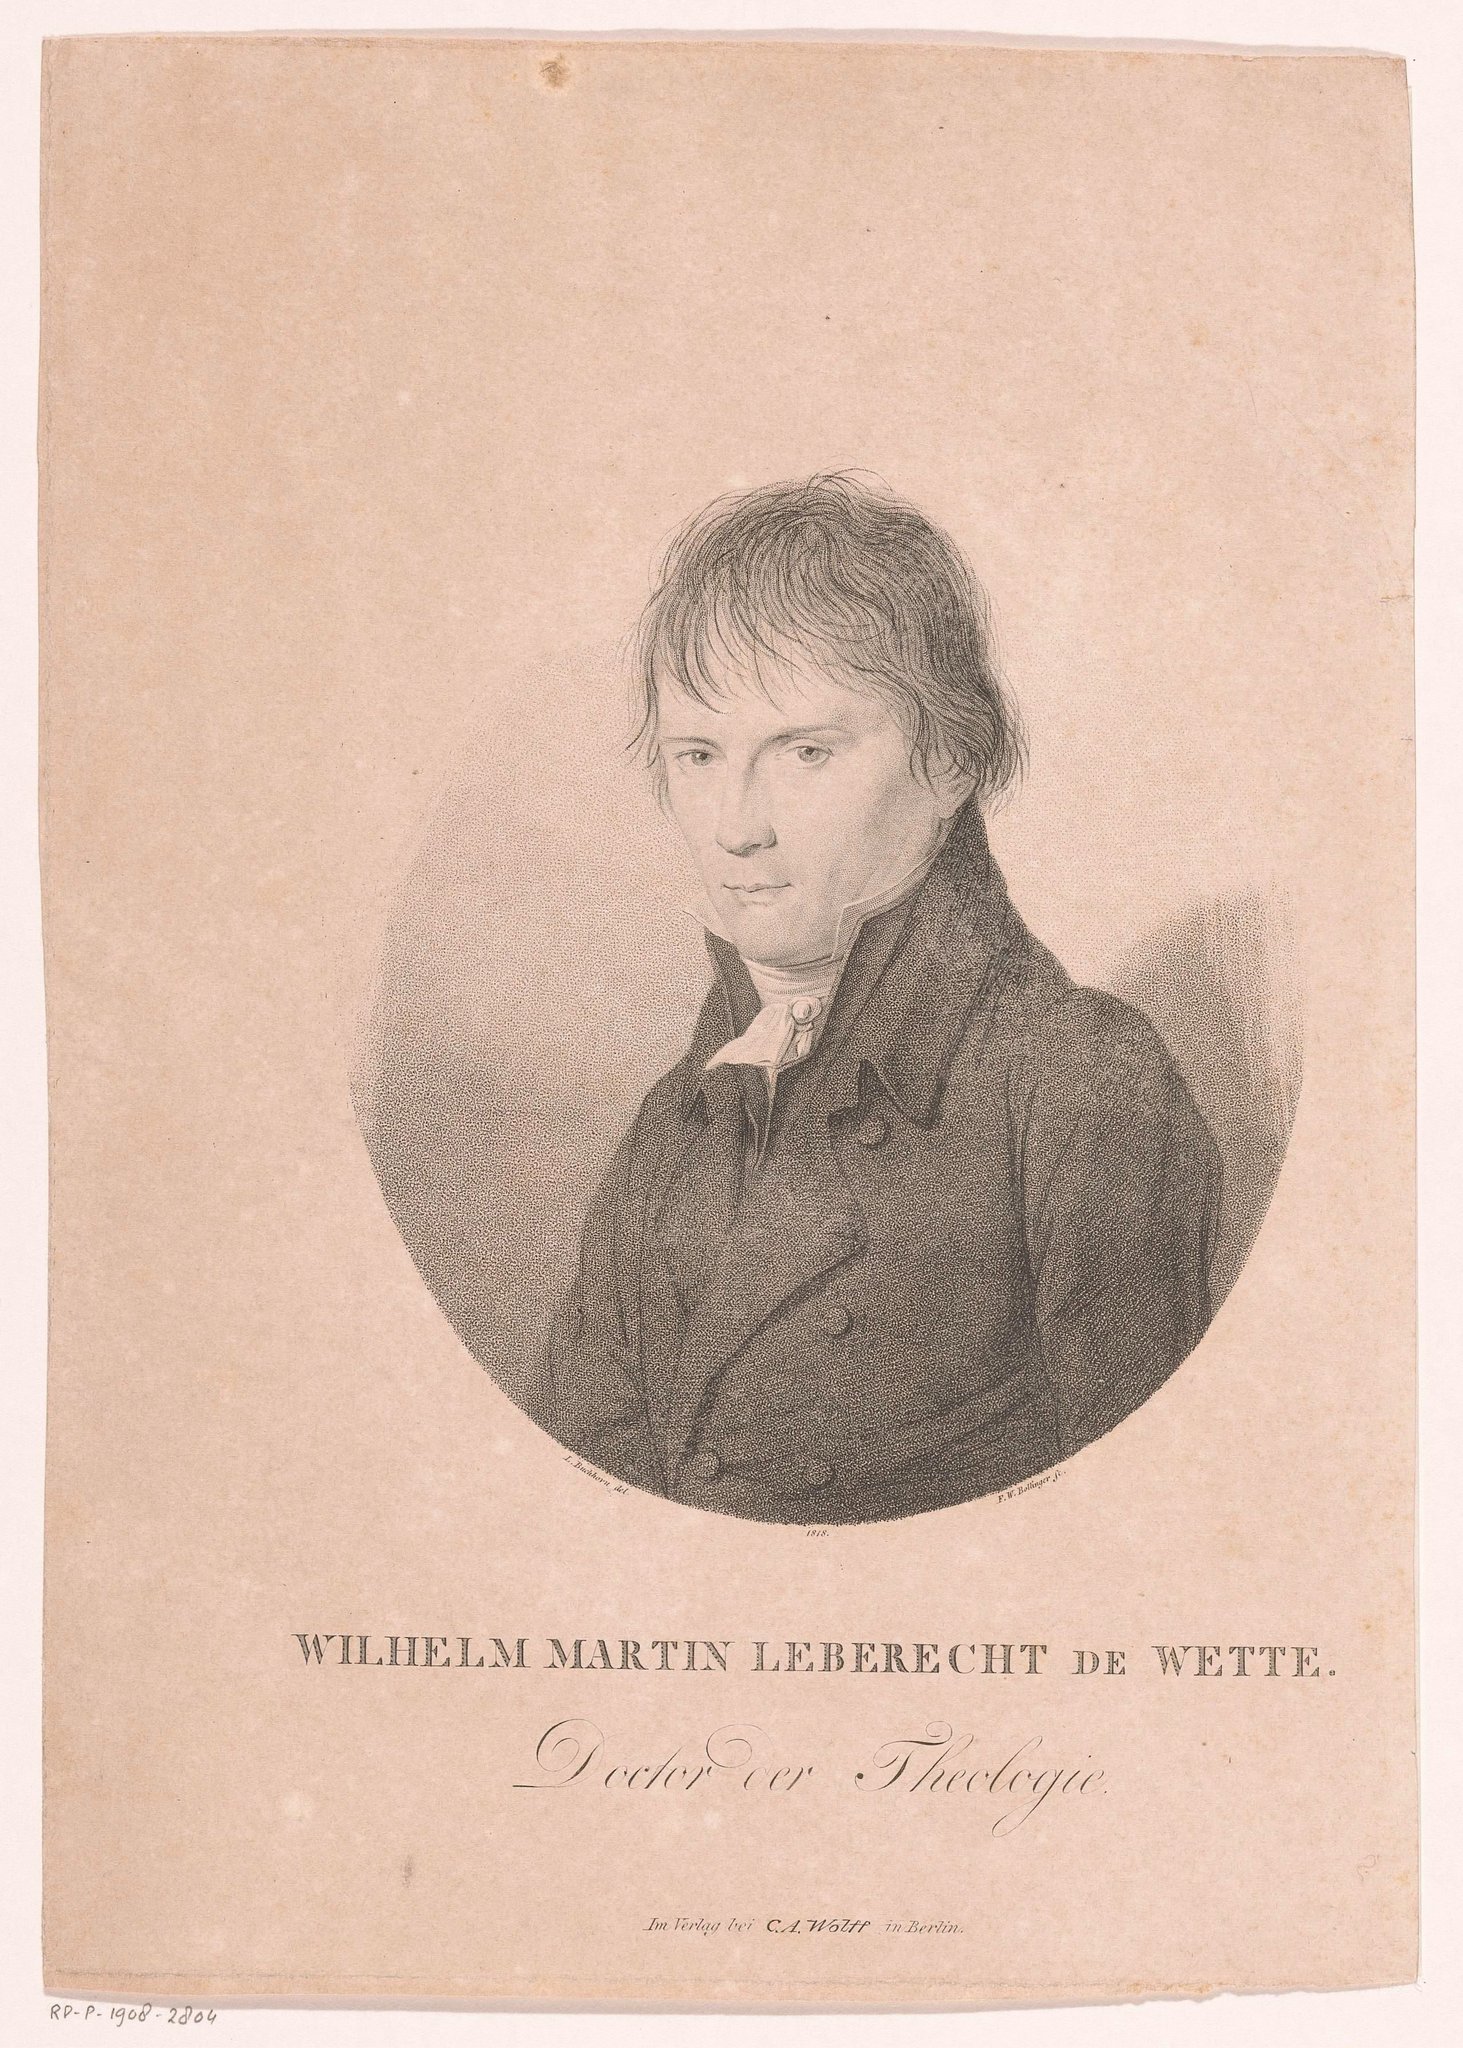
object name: print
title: Portret van Wilhelm Martin Leberecht de Wette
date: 1818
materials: paper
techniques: stippling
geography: berlin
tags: historical persons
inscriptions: collector's mark: Lugt 2228